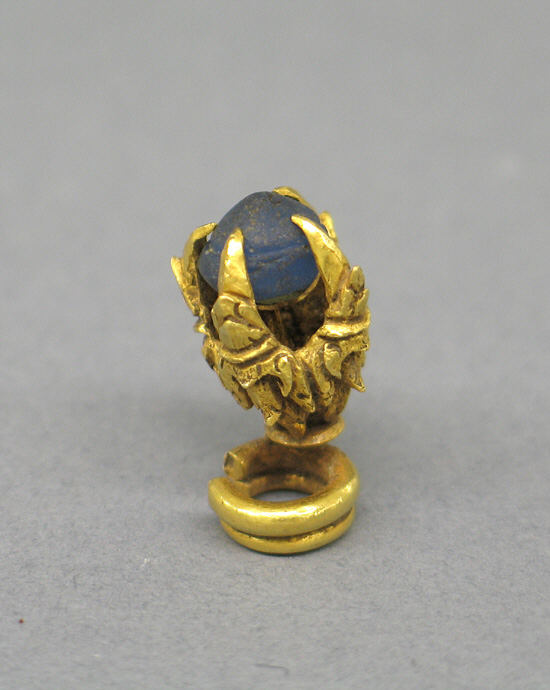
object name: ear clip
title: Ear Clip with Light Blue Stone in Four Prong Setting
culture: indonesian, javanese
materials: gold, stone